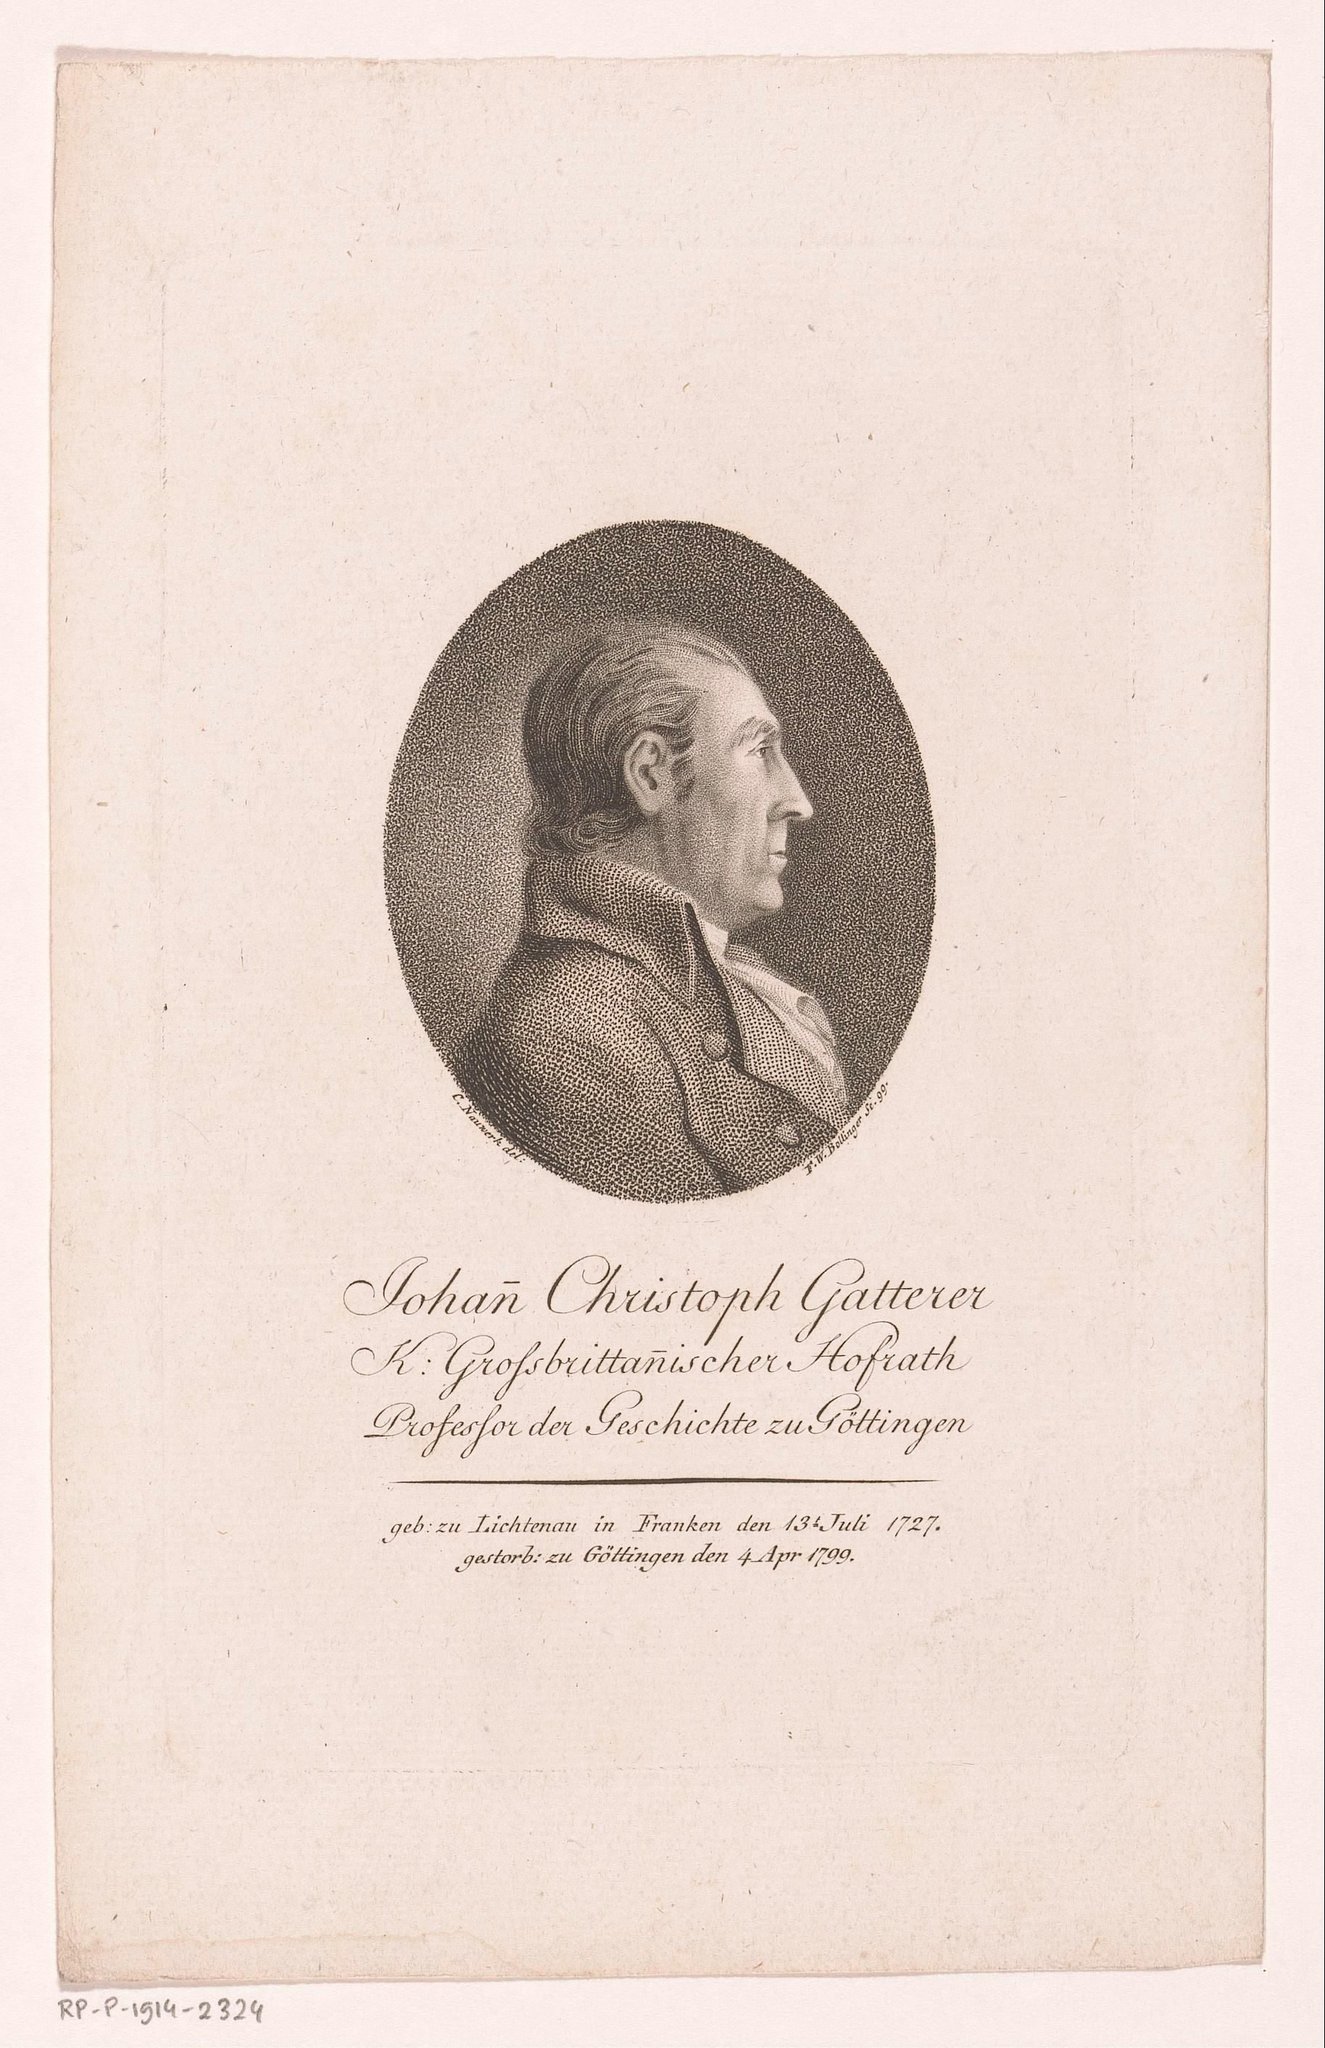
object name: print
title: Portret van Johann Christoph Gatterer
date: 1799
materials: paper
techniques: stippling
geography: berlin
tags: historical persons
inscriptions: collector's mark: Lugt 2228